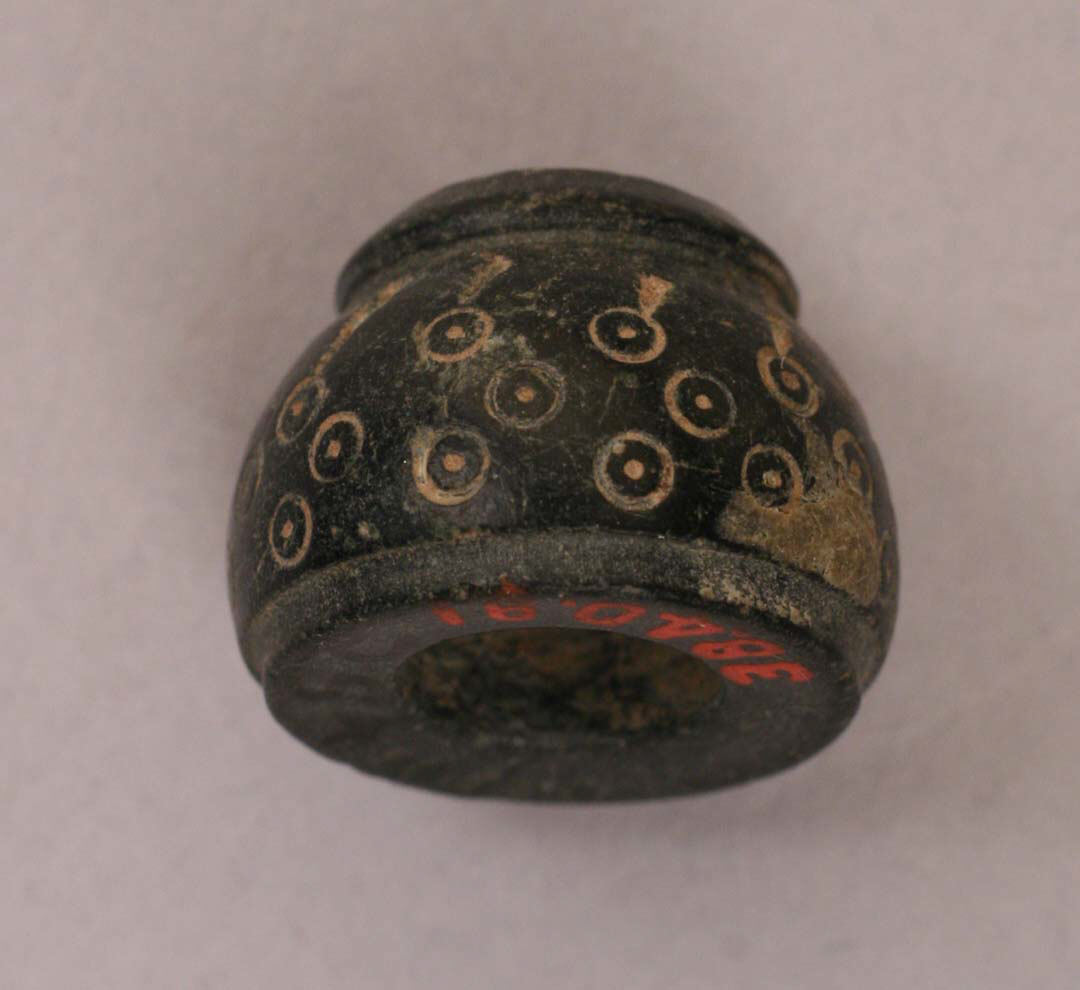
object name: button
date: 701-1000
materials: stone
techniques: carving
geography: iran